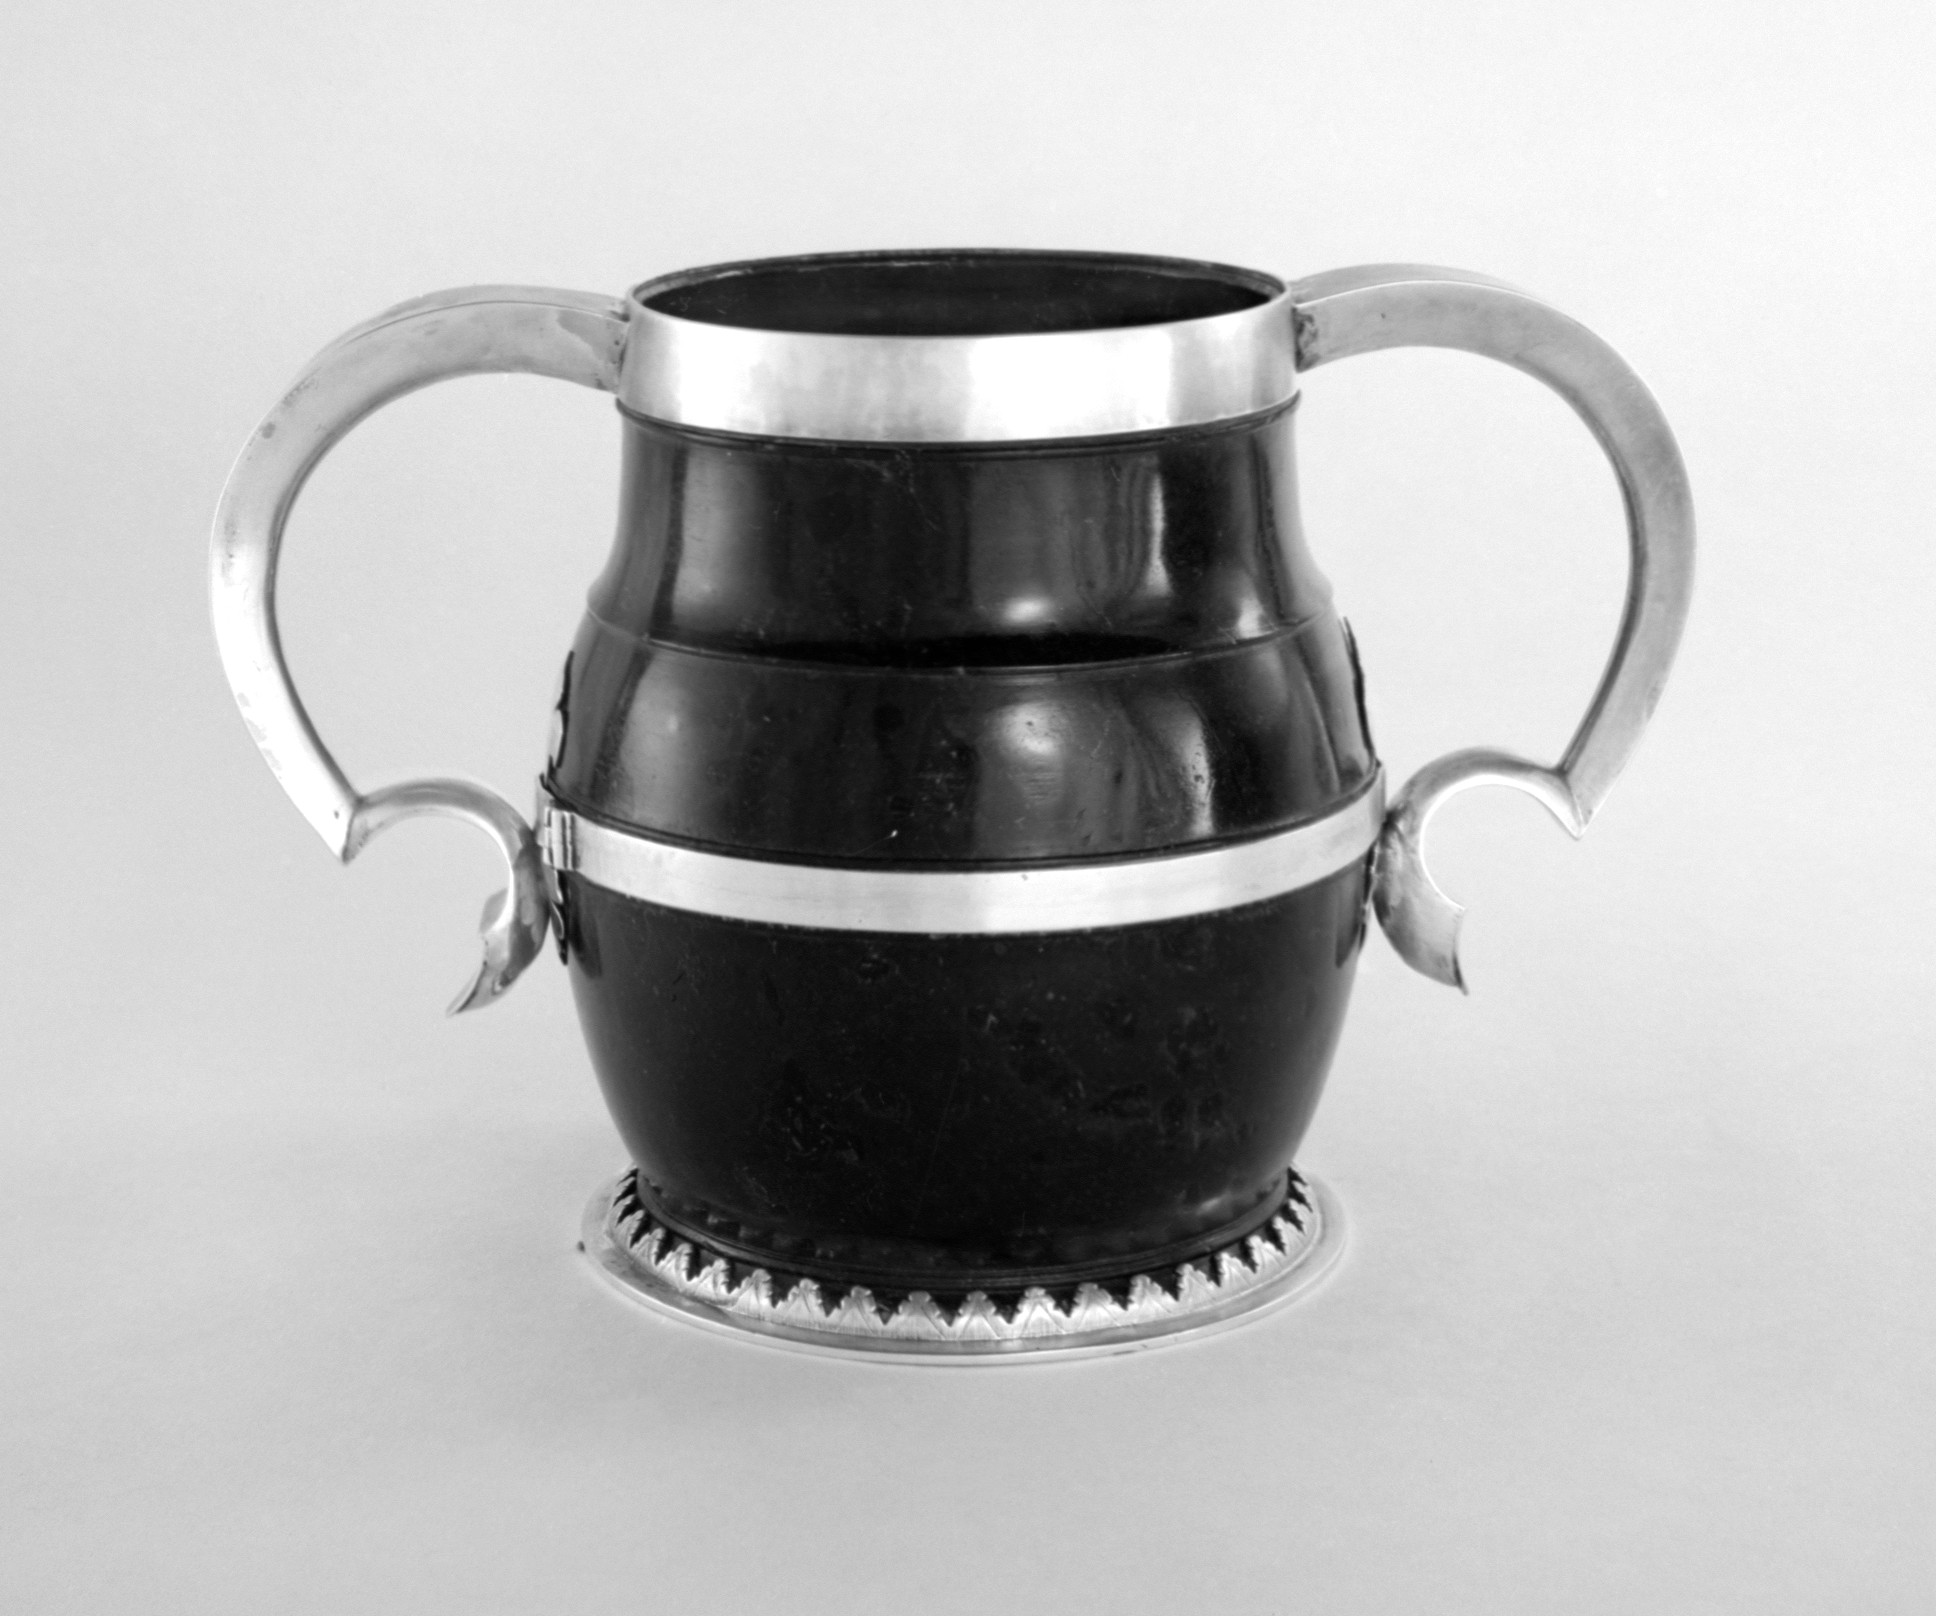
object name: cup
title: Two-handled cup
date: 1650-1660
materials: stone, silver